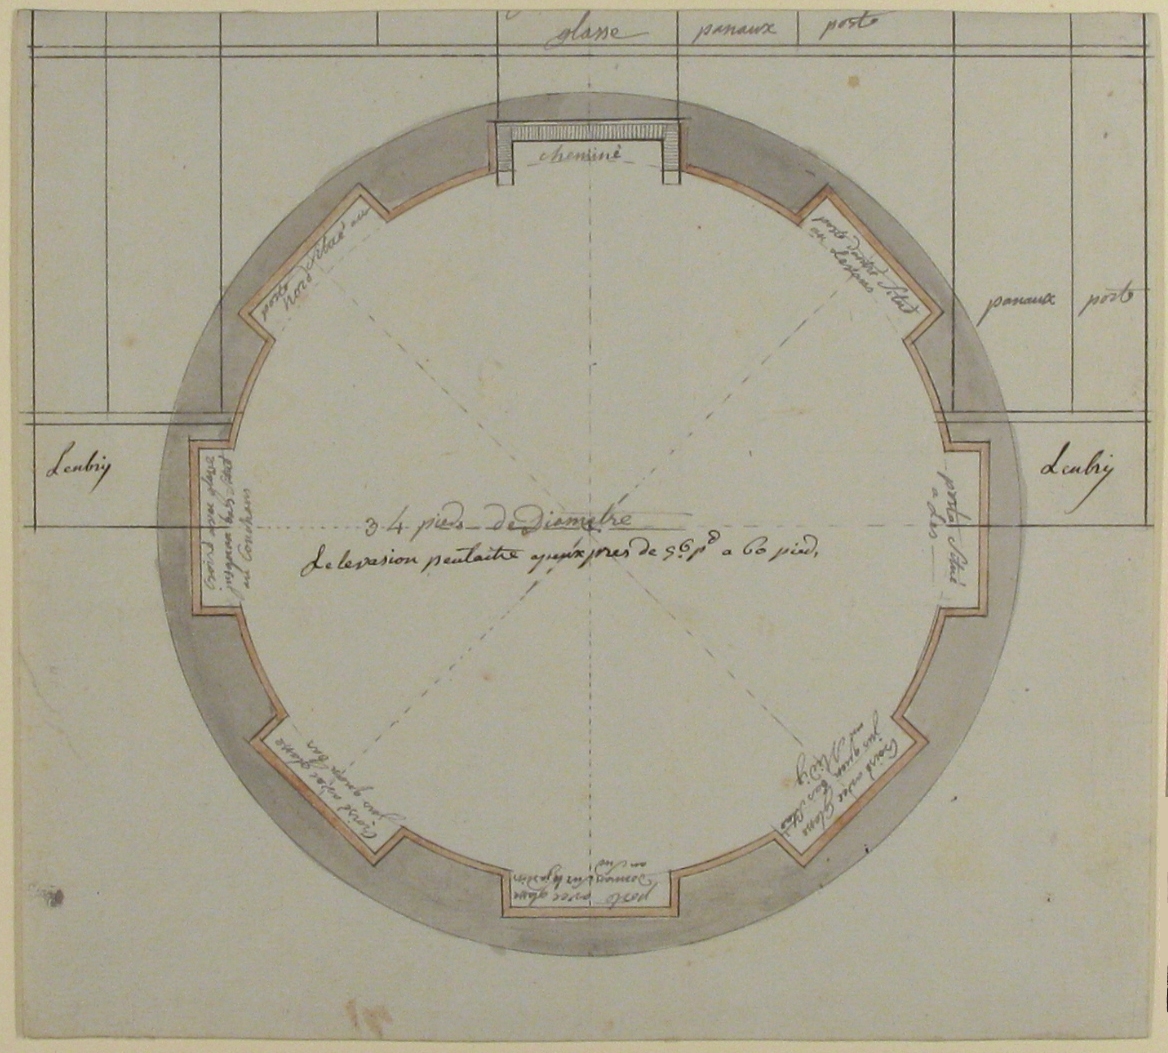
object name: drawing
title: Plan for a Circular Room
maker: anonymous, french, 18th century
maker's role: artist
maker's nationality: french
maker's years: 1700-1800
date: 1770-1790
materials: ink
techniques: brush, pen, wash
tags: architecture